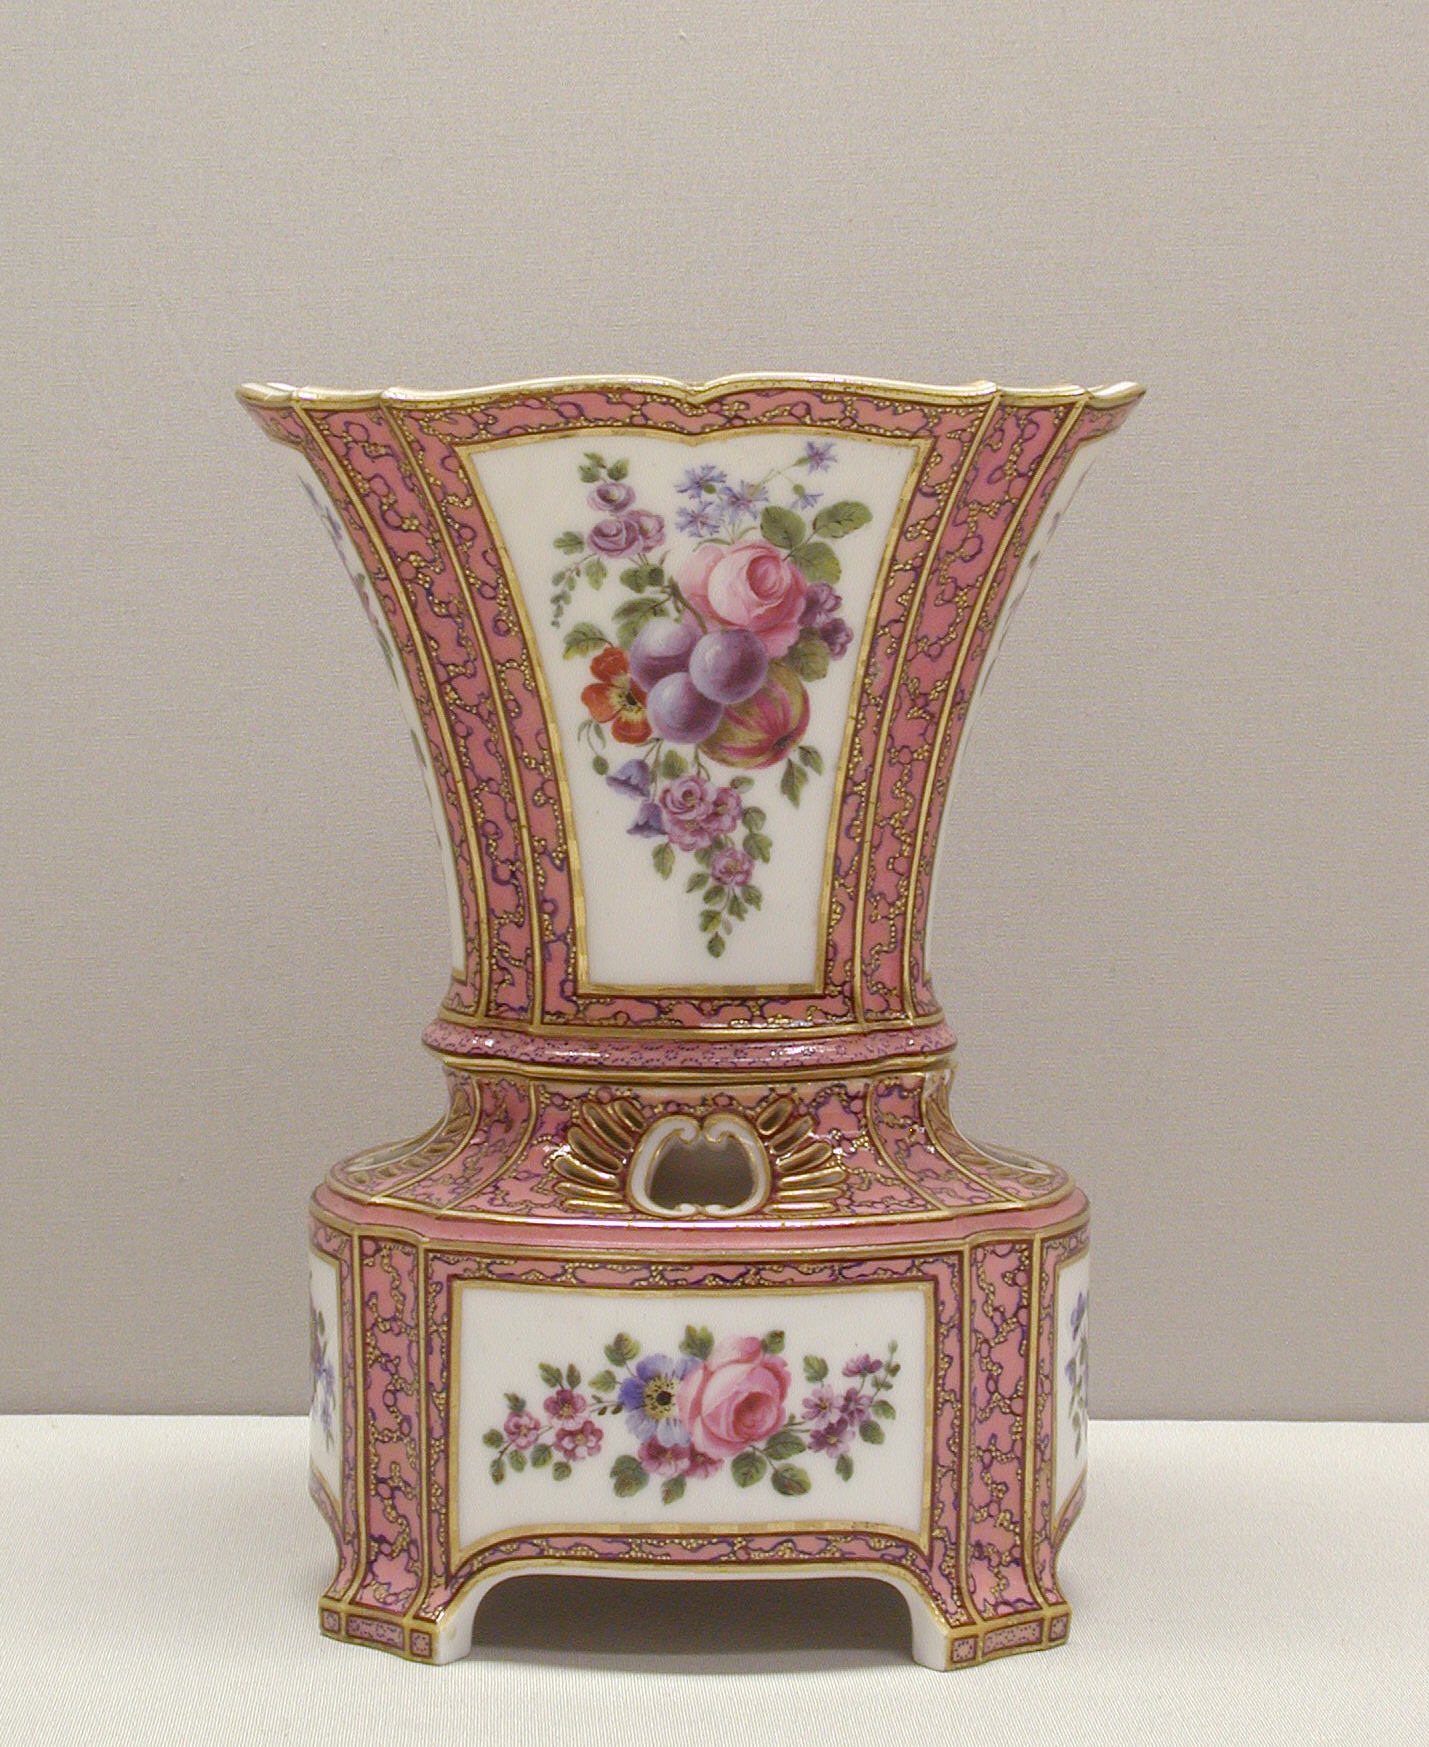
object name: vase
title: Vase (Vase hollandois)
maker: sèvres manufactory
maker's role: manufactory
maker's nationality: french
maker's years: 1740-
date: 1761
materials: soft paste porcelain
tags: fruit,flowers